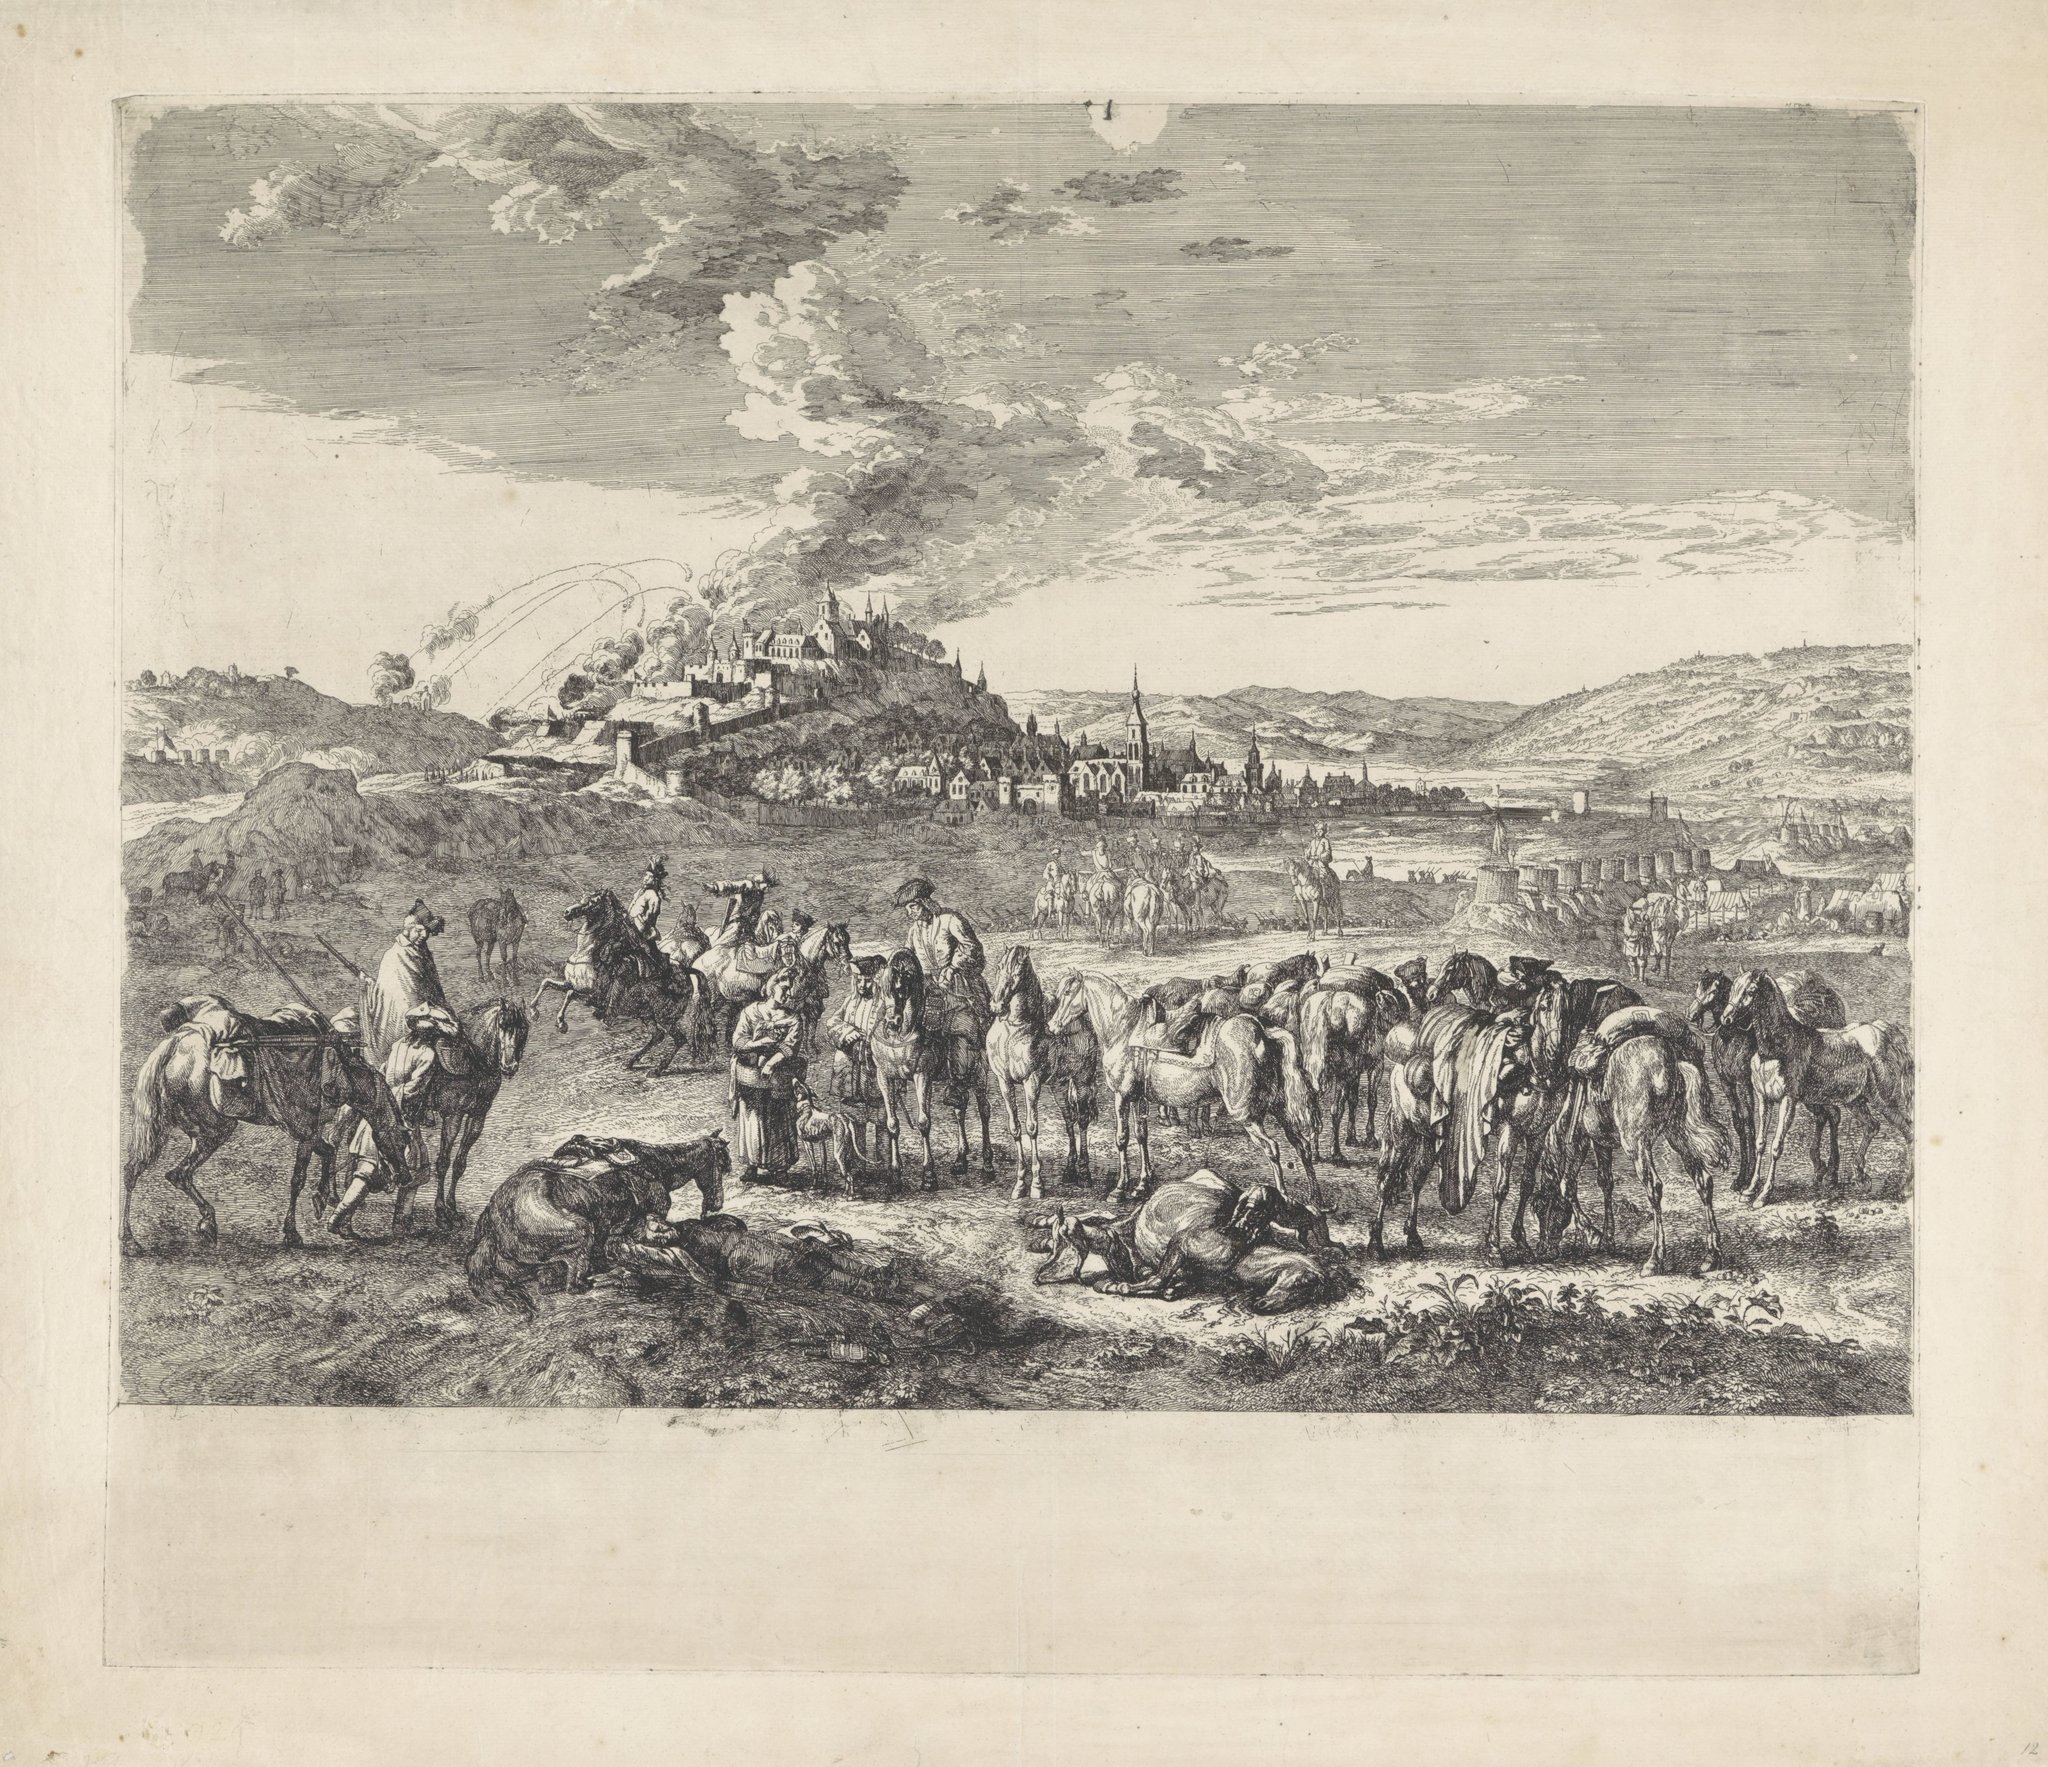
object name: print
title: Beleg van het kasteel van Namen, 1695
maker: jan van huchtenburg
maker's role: draughtsman, painter, print maker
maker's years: 1647-1733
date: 1695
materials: paper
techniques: etching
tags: siege, position war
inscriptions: collector's mark: Lugt 240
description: De beschieting van de citadel van Namen door de Geallieerden in september 1695. Op de voorgrond rustende soldaten en paarden.